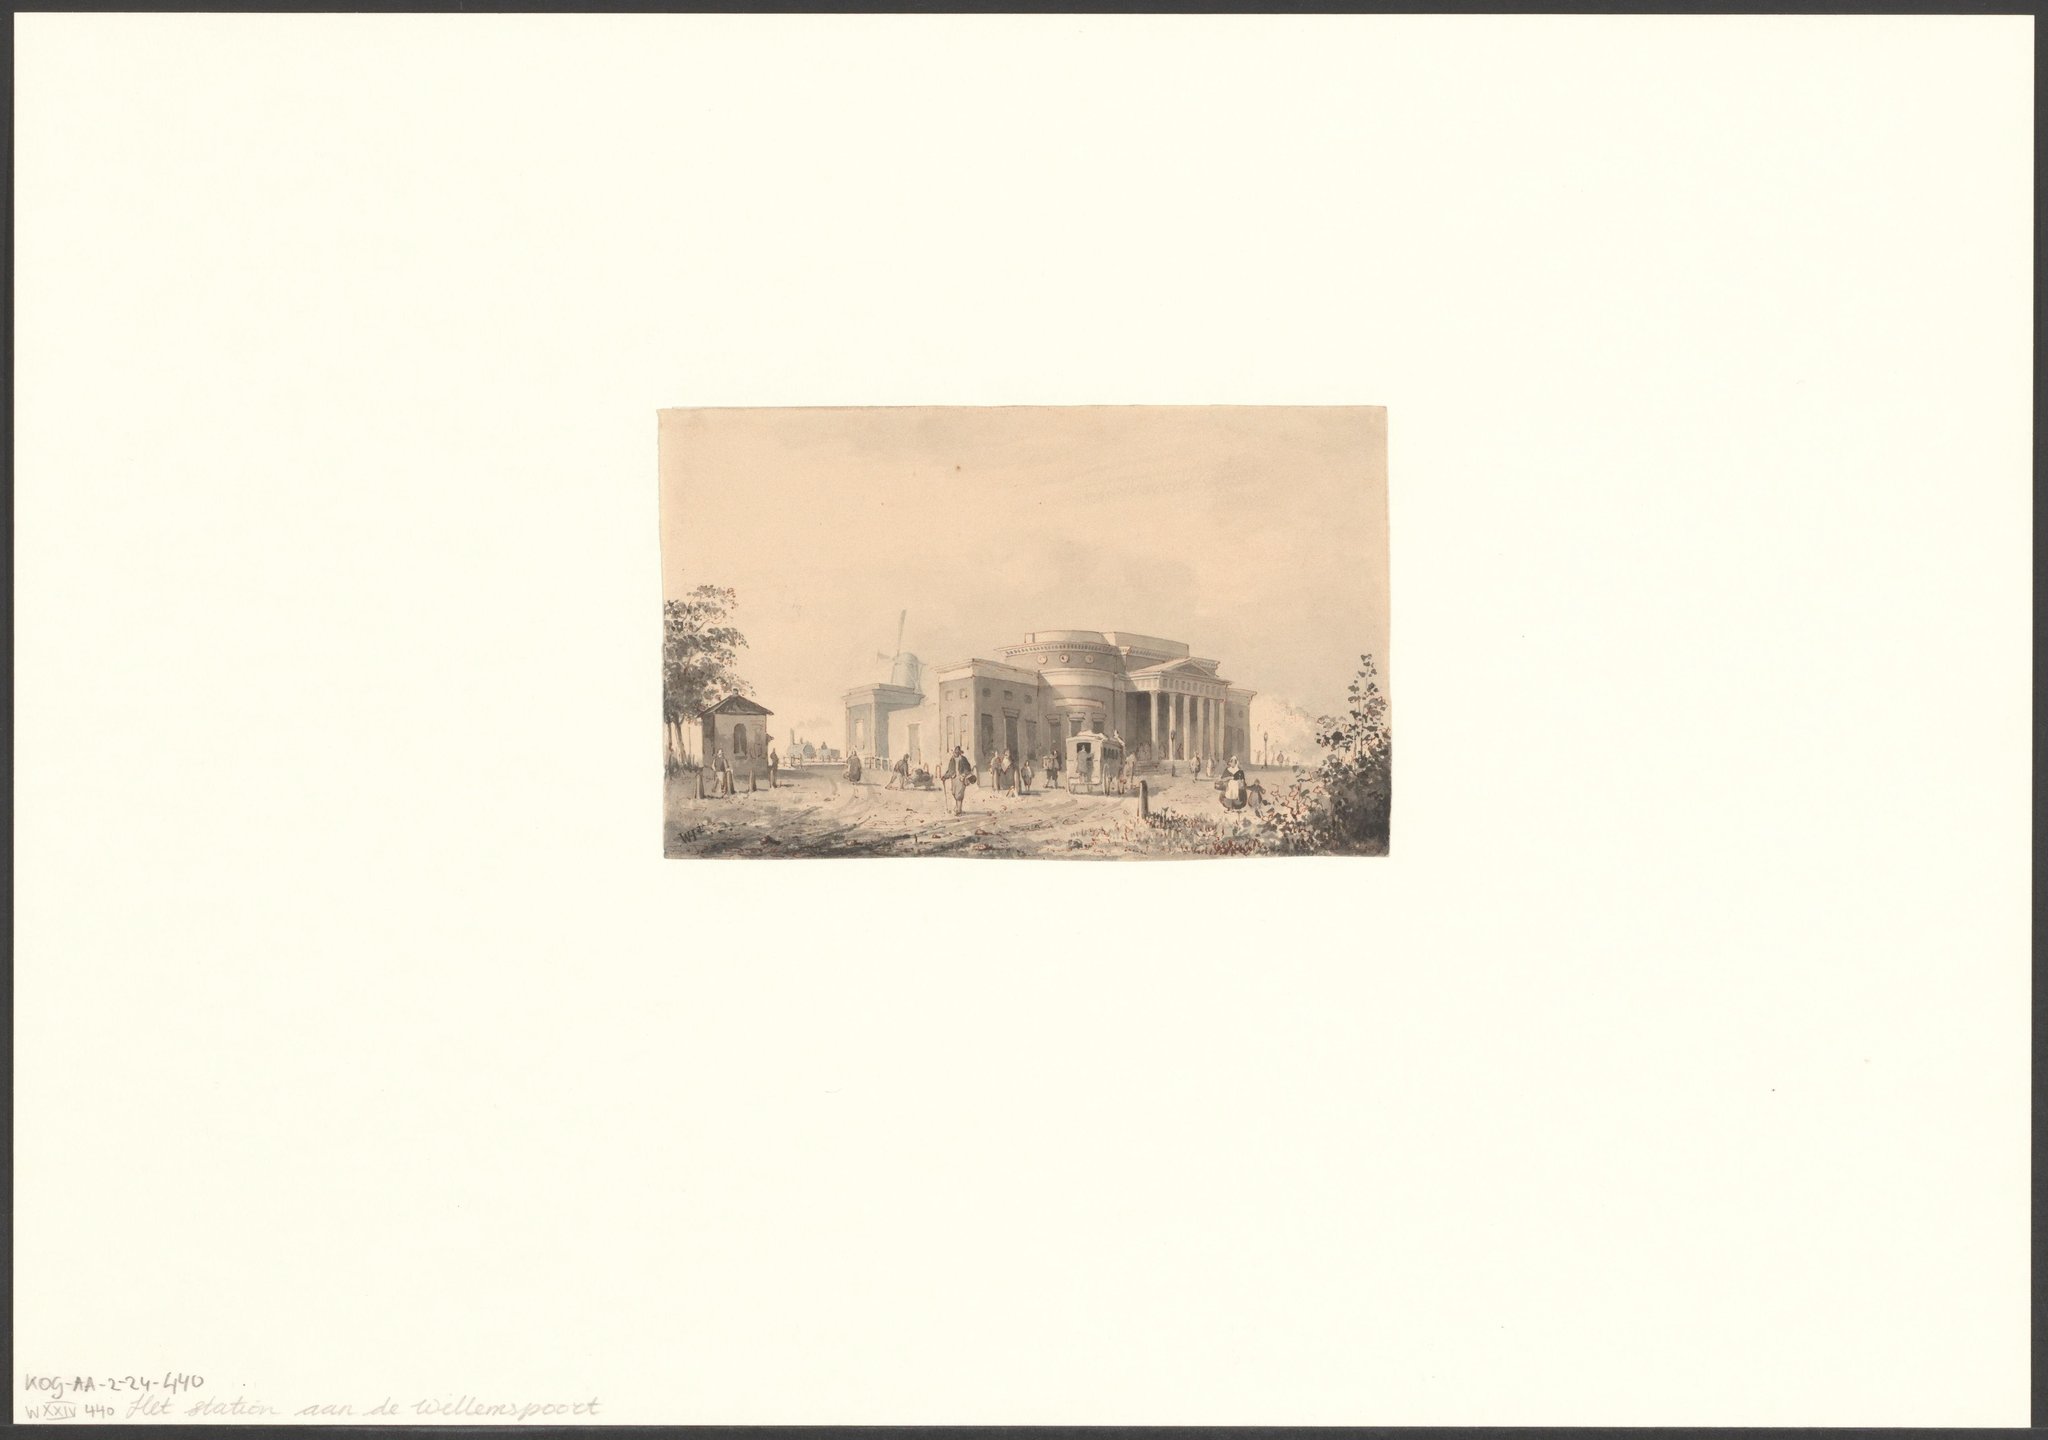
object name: drawing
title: Gezicht op de Haarlemmerweg gezien naar het Station Willemspoort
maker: willem hekking jr.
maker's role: print maker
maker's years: 1825-1904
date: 1842-1904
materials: ink, paper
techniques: brush, pen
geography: amsterdam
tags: city-view in general; 'veduta', station; shelter (railway, tramway), city-gate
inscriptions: signature: ‘WHjr’, collector's mark: Lugt 800a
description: Tekening binnen de Atlas Van Eck ingedeeld op wijknummer 24.